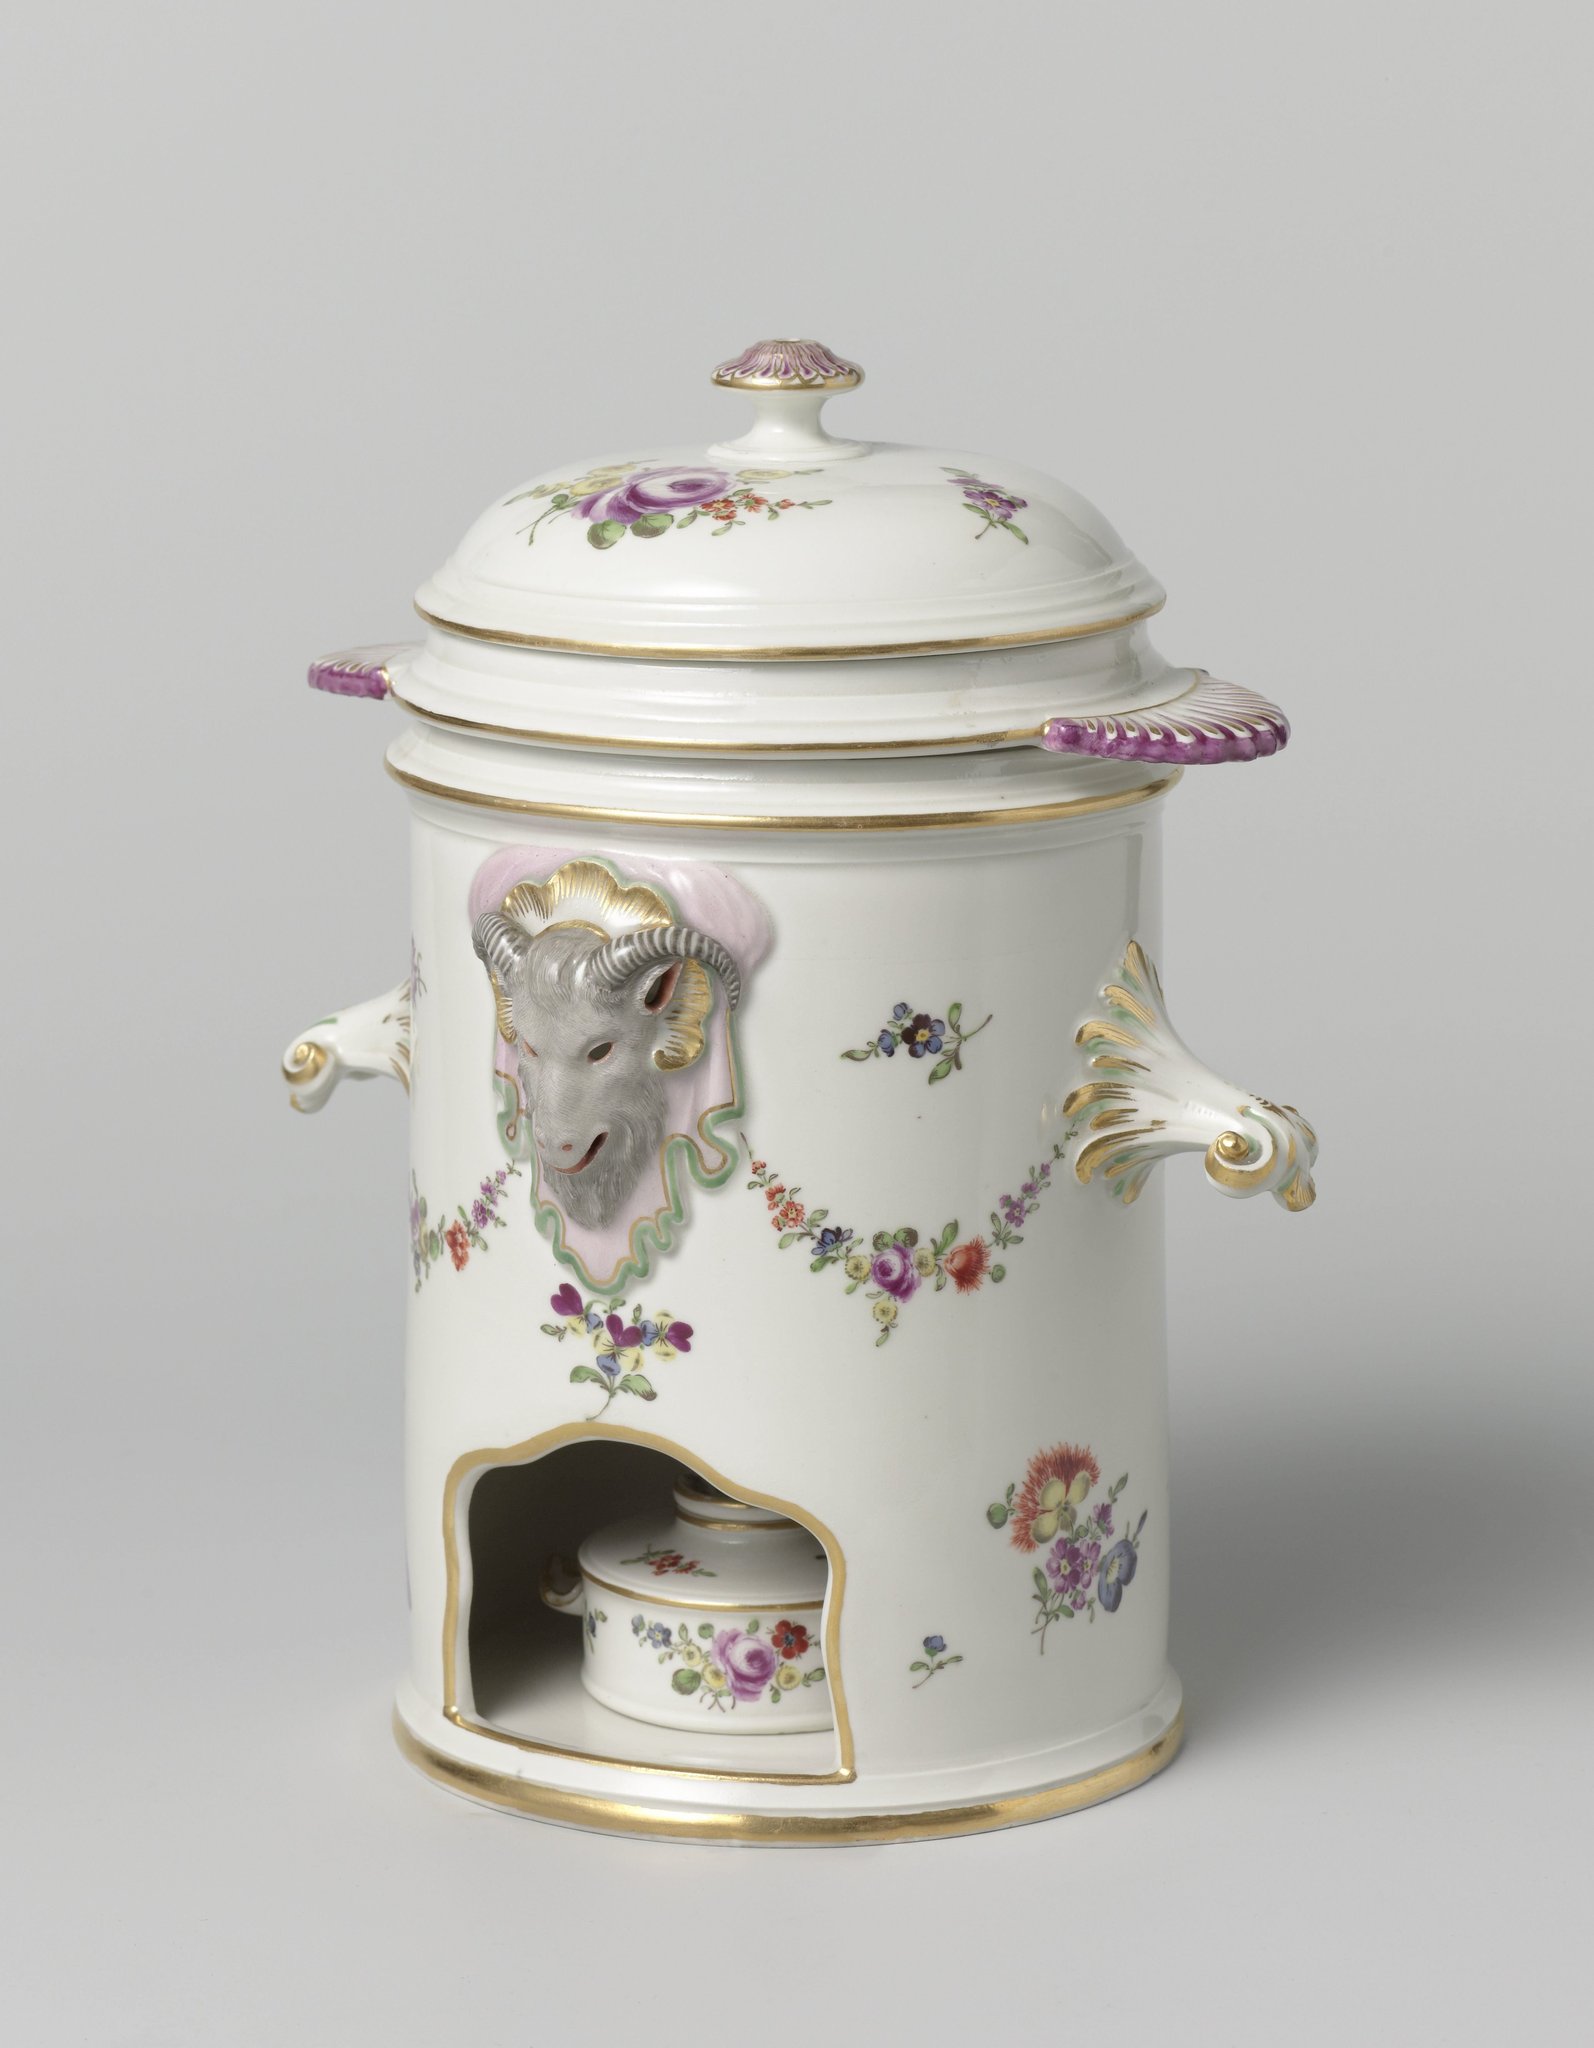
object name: dish warmer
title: Réchaud with rams, garlands and bouquets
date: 1770-1780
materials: glaze, gold, paint, porcelain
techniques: firing, forming, gilding, relief, turning, vitrification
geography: ludwigsburg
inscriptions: mark: ‘IP4’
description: Porzellan-Manufaktur Ludwigsburg Ludwigsburg, c. 1770–1780 hard-paste porcelain